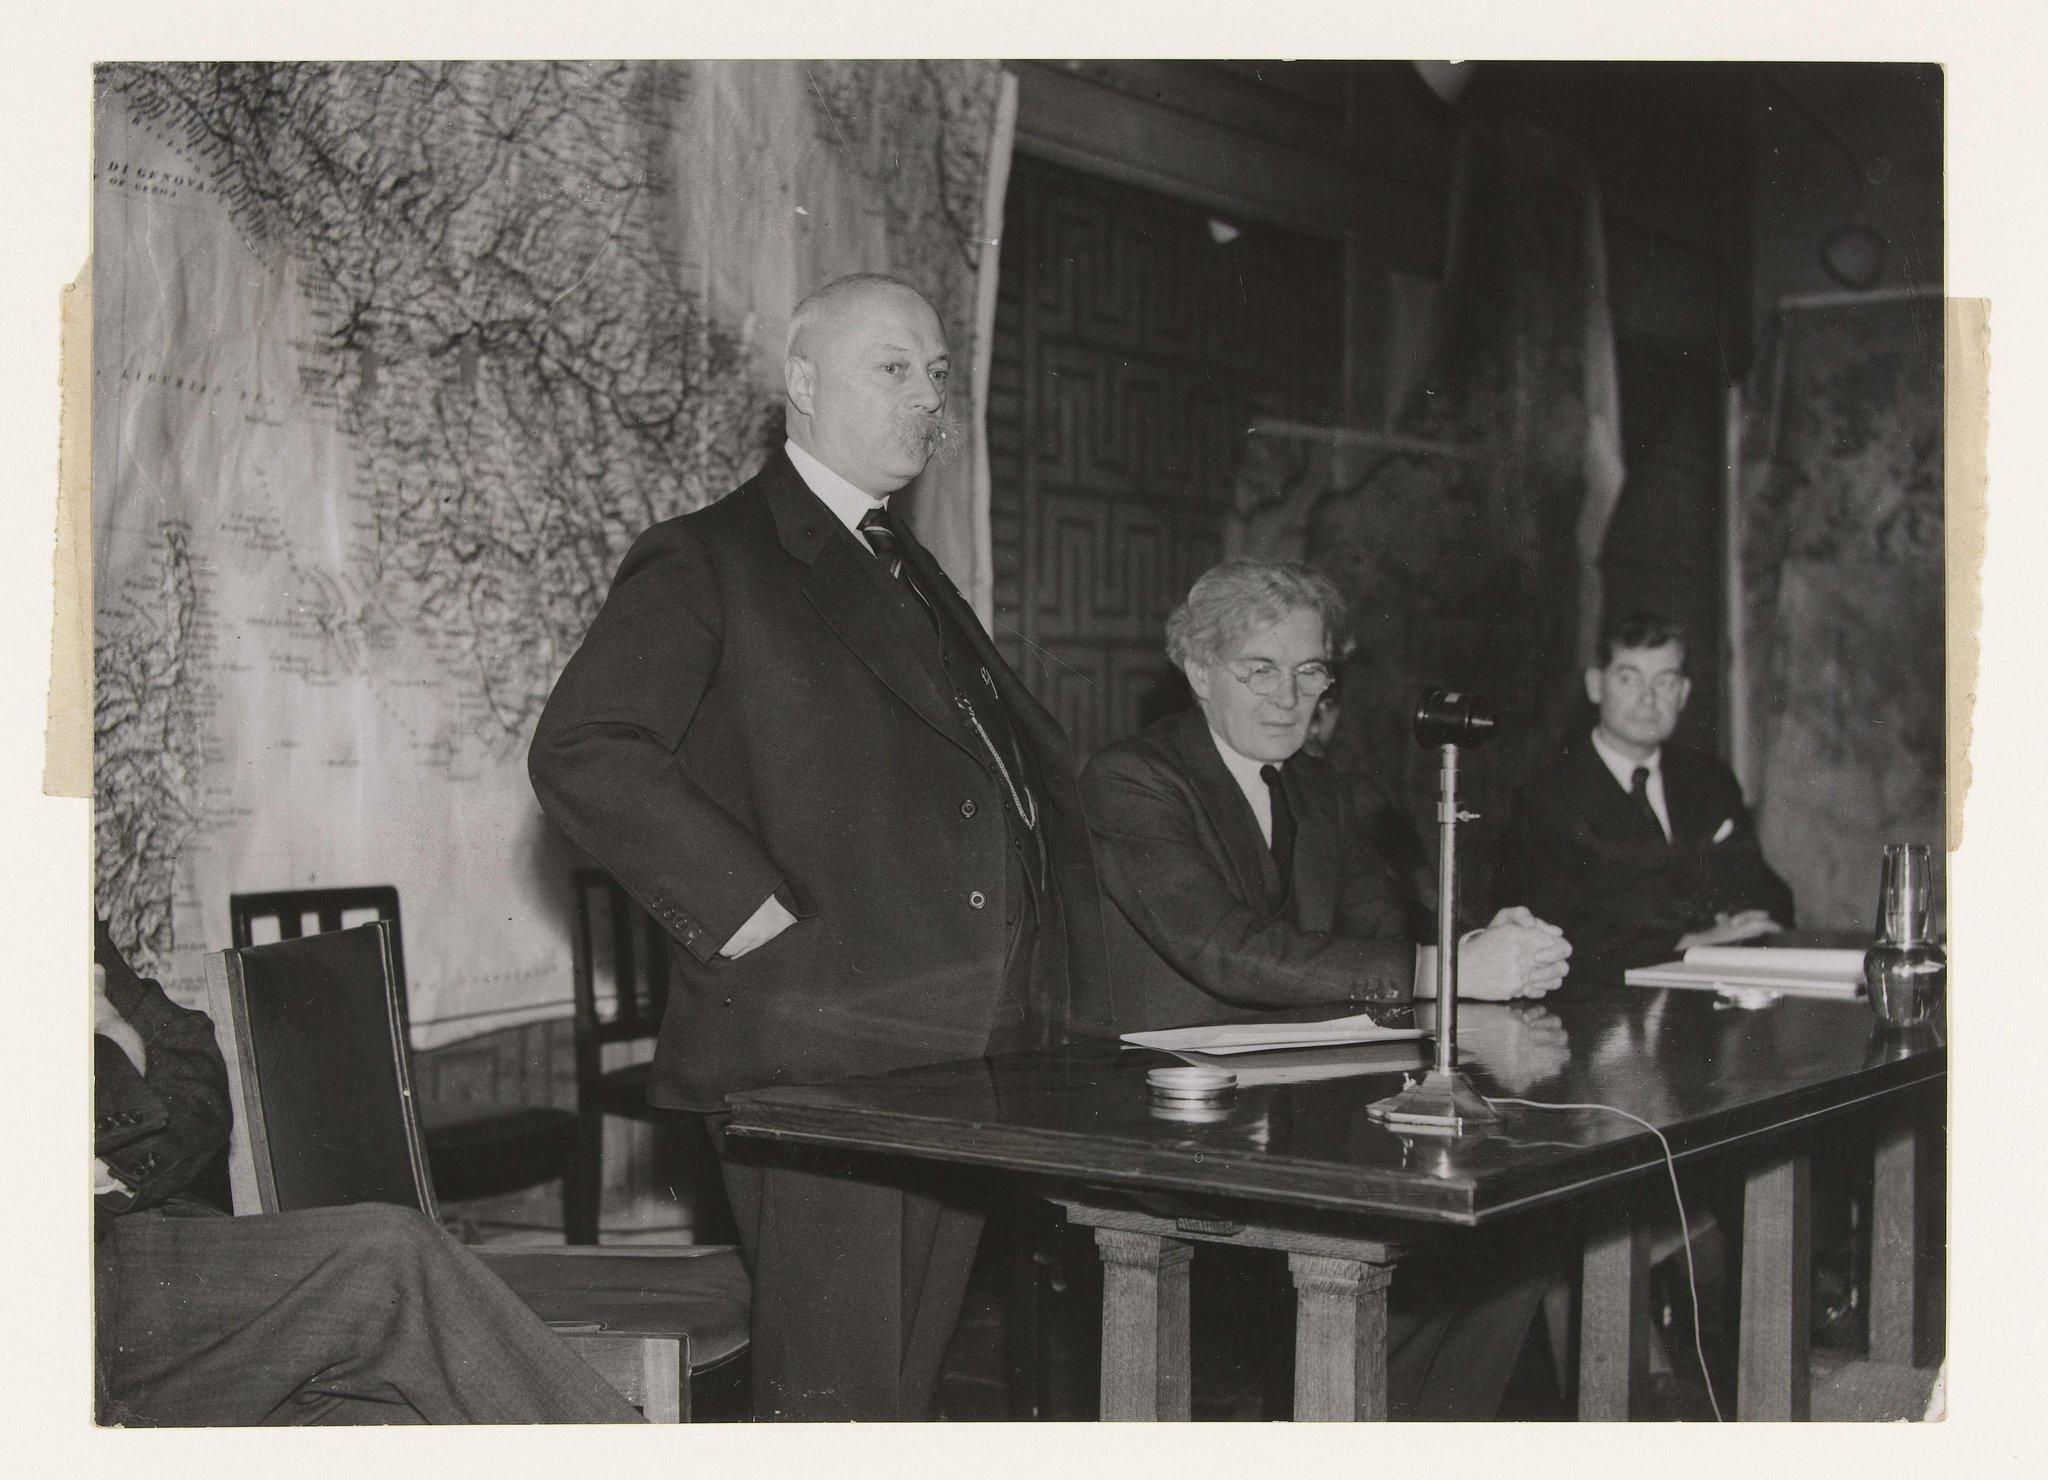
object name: documentary photograph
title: Premier Pieter Gerbrandy houdt in Londen een persbijeenkomst over terugkeer naar Nederland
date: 1945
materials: photographic support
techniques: photography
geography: london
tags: the hague, pieter sjoerds gerbrandy, publisher, politician, london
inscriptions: number: ‘482853’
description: Minister-president Gerbrandy staat achter een tafel, tijdens de persbijeenkomst in het Londense Ministerie van Informatie, met naast hem een zittende Brendan Bracken, minister van informatie en kondigt de terugkeer van de regering in ballingschap naar Nederland aan.